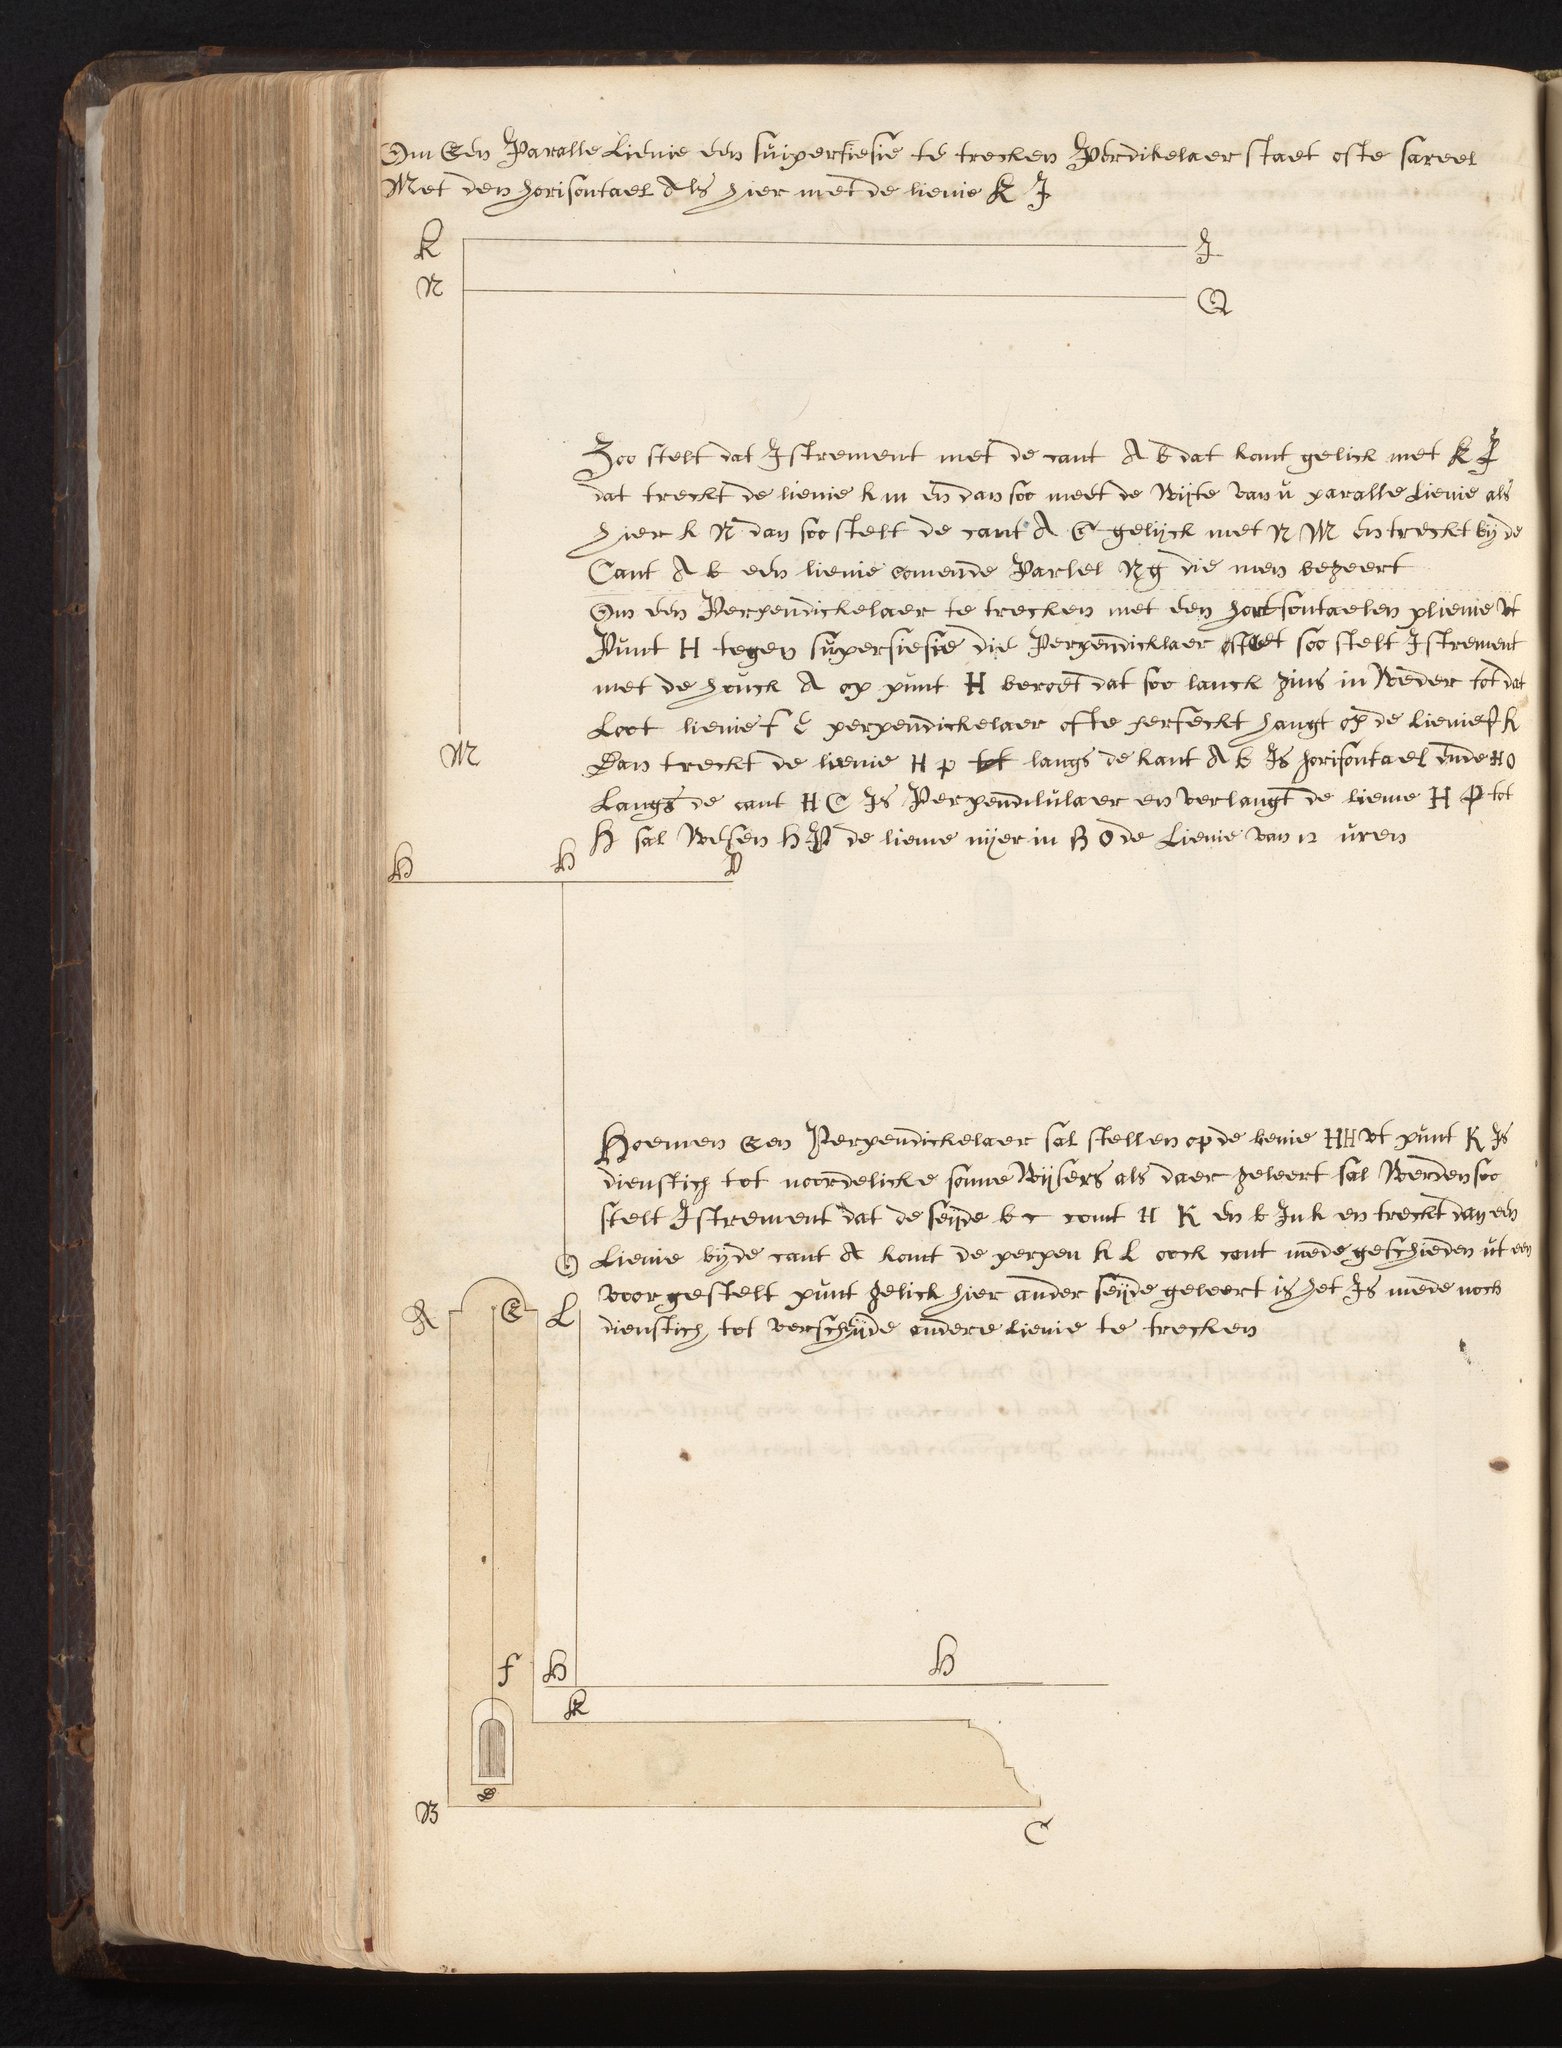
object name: drawing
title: Onderdeel van een zonnewijzer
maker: Anonymous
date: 1650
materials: ink, paper, pencil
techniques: brush, pen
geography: low countries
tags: sundial